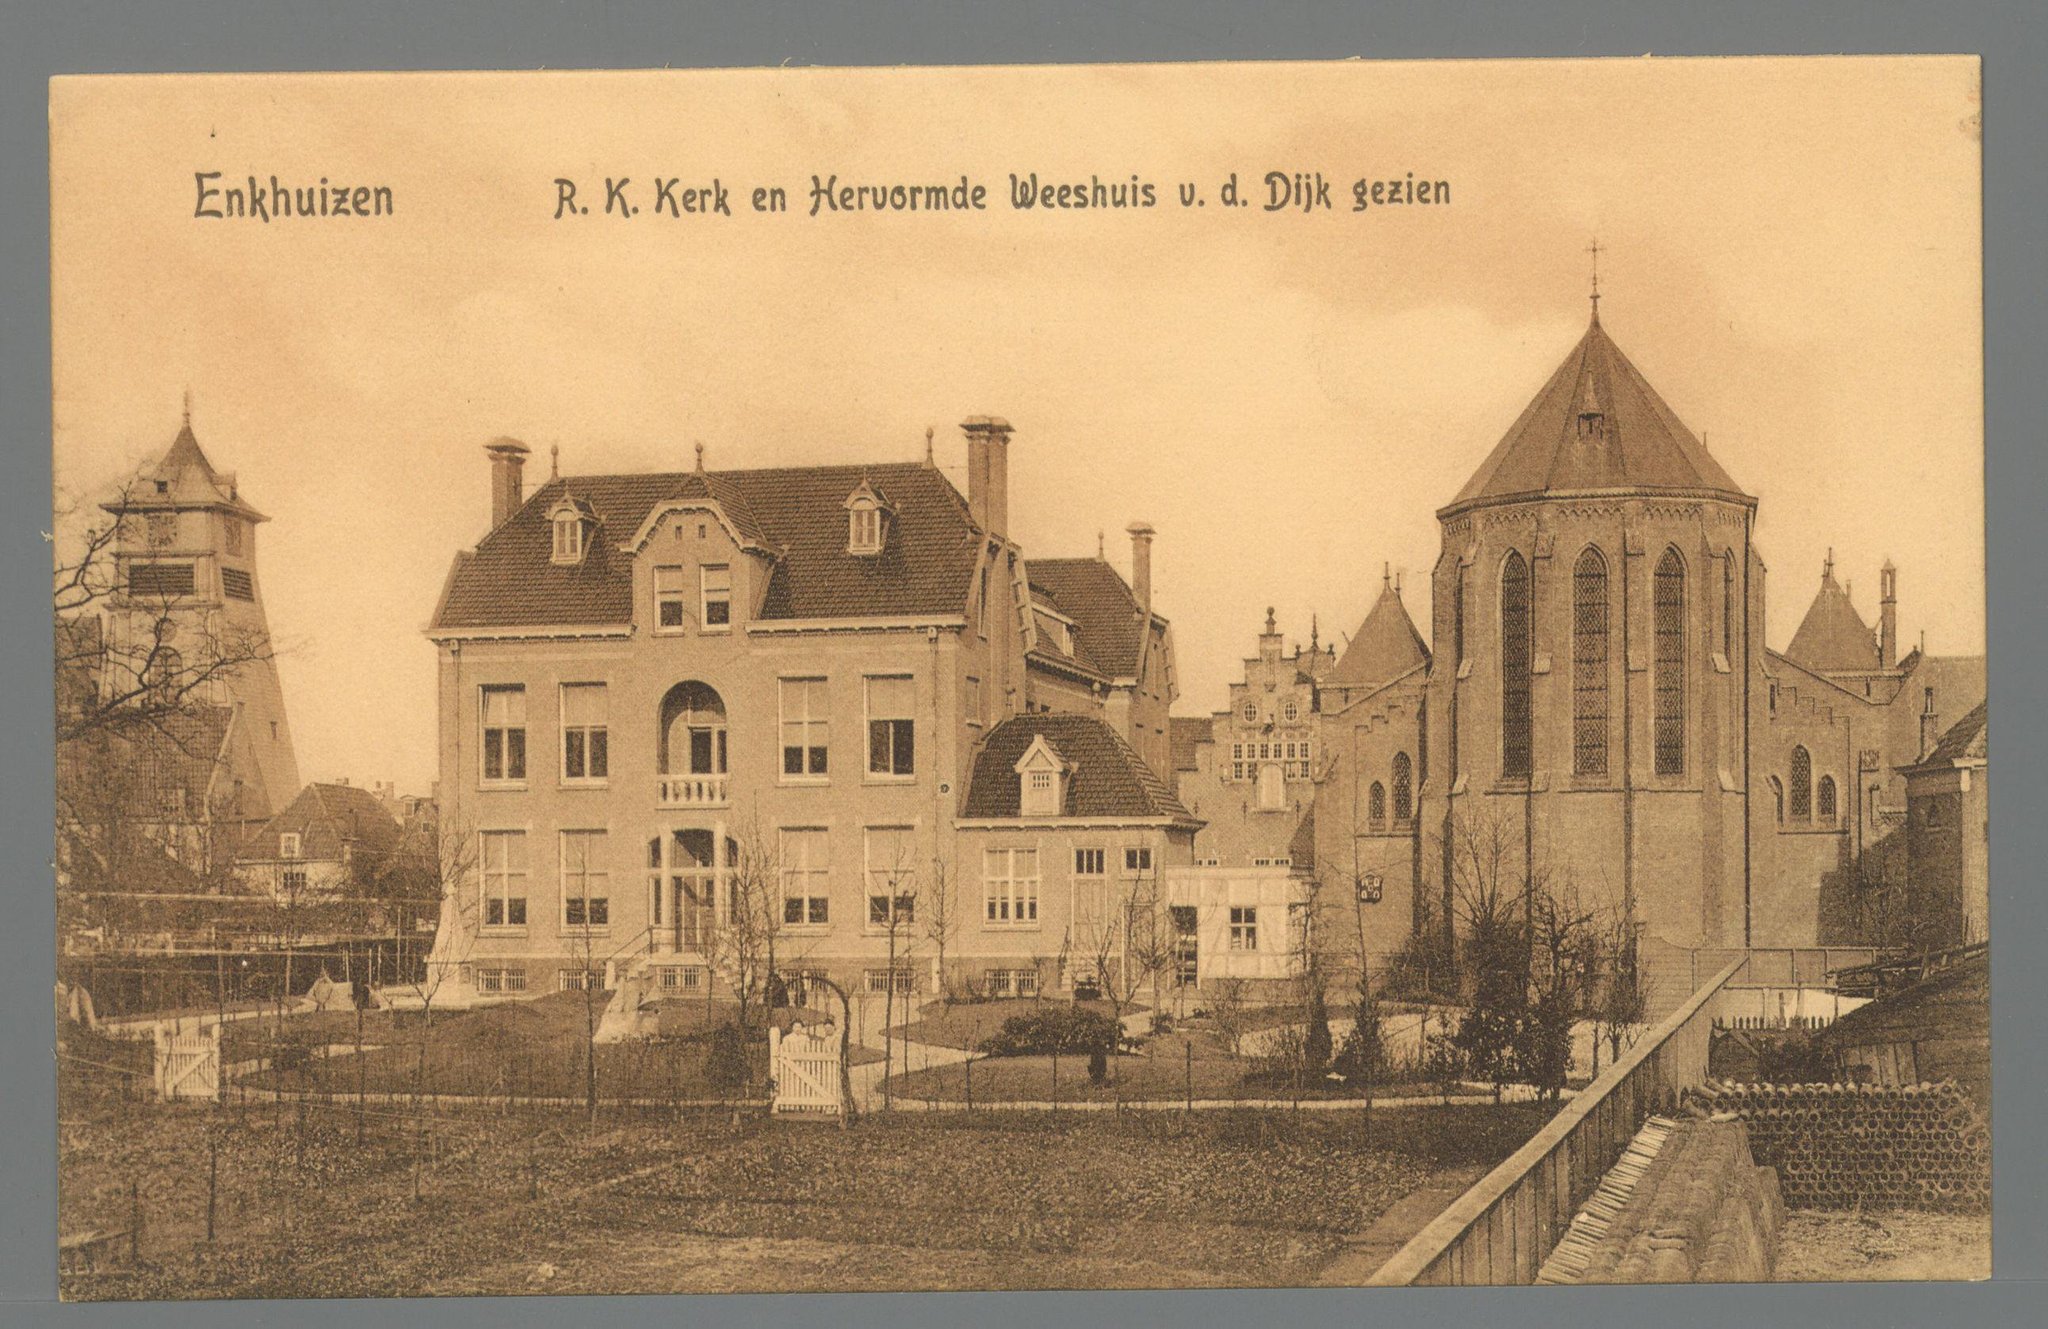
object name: photomechanical print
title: Enkhuizen. R.K. Kerk en Hervormde Weeshuis v.d. dijk gezien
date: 1906-1919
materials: cardboard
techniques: photograph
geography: enkhuizen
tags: parts of church exterior and annexes: campanile, city-view, and landscape with man-made constructions, church (exterior), orphanage, enkhuizen